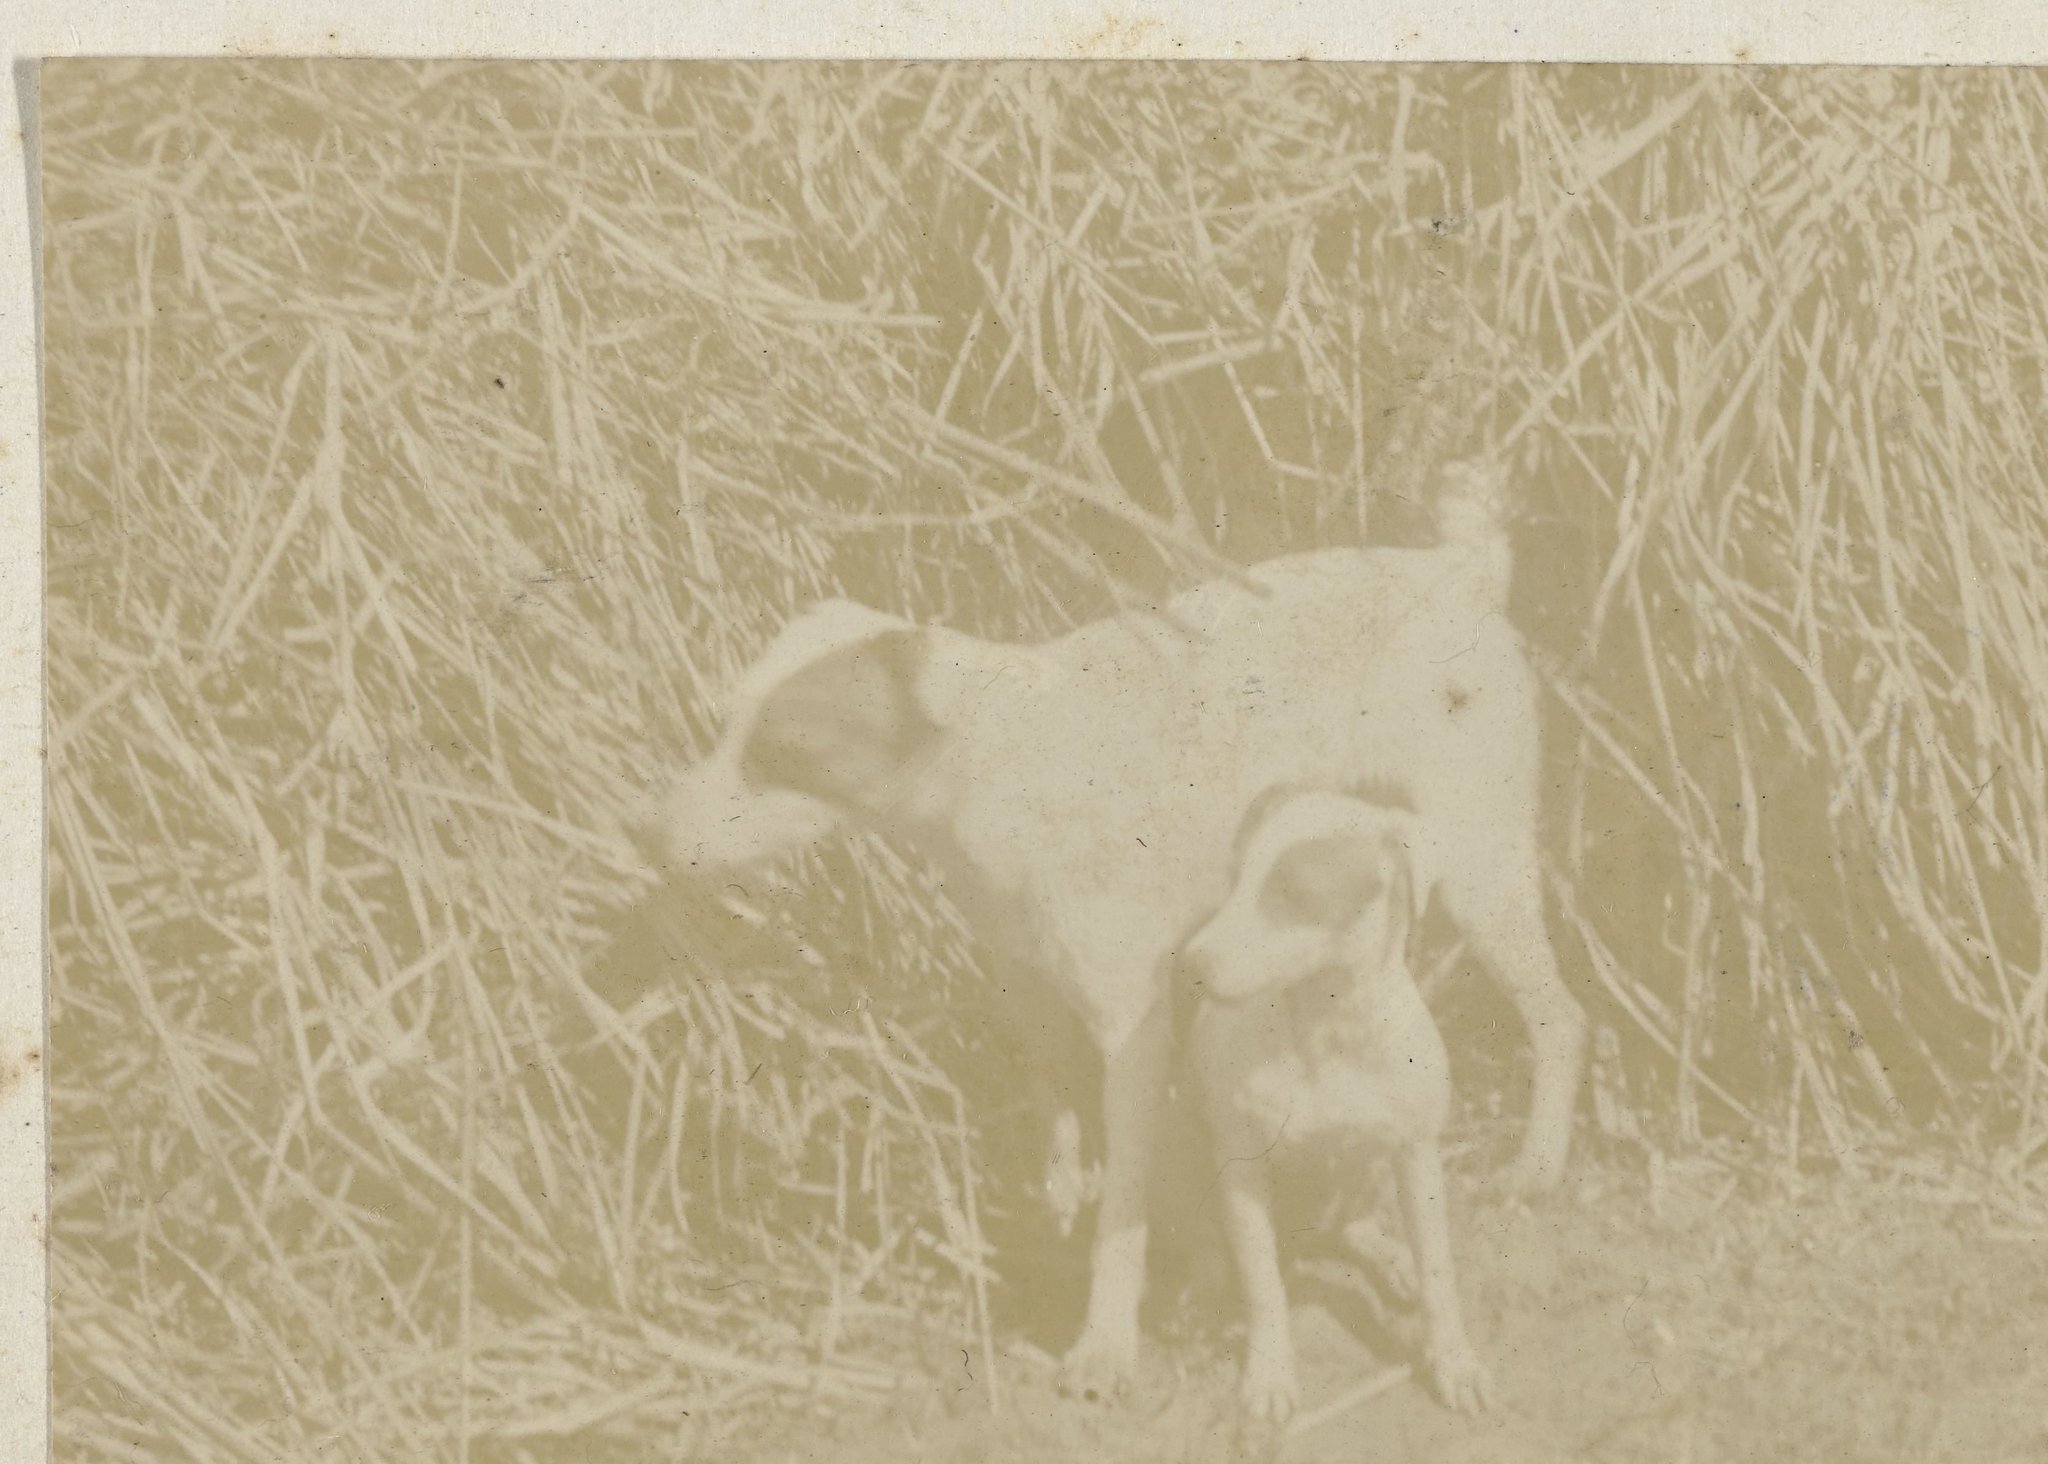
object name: photograph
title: 5 kiekjes te Djattie roenggo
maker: Anonymous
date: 1890-1910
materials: cardboard, paper, photographic support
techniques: gelatin silver print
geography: netherlands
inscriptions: caption: ‘5 kiekjes te Djattie roenggo’